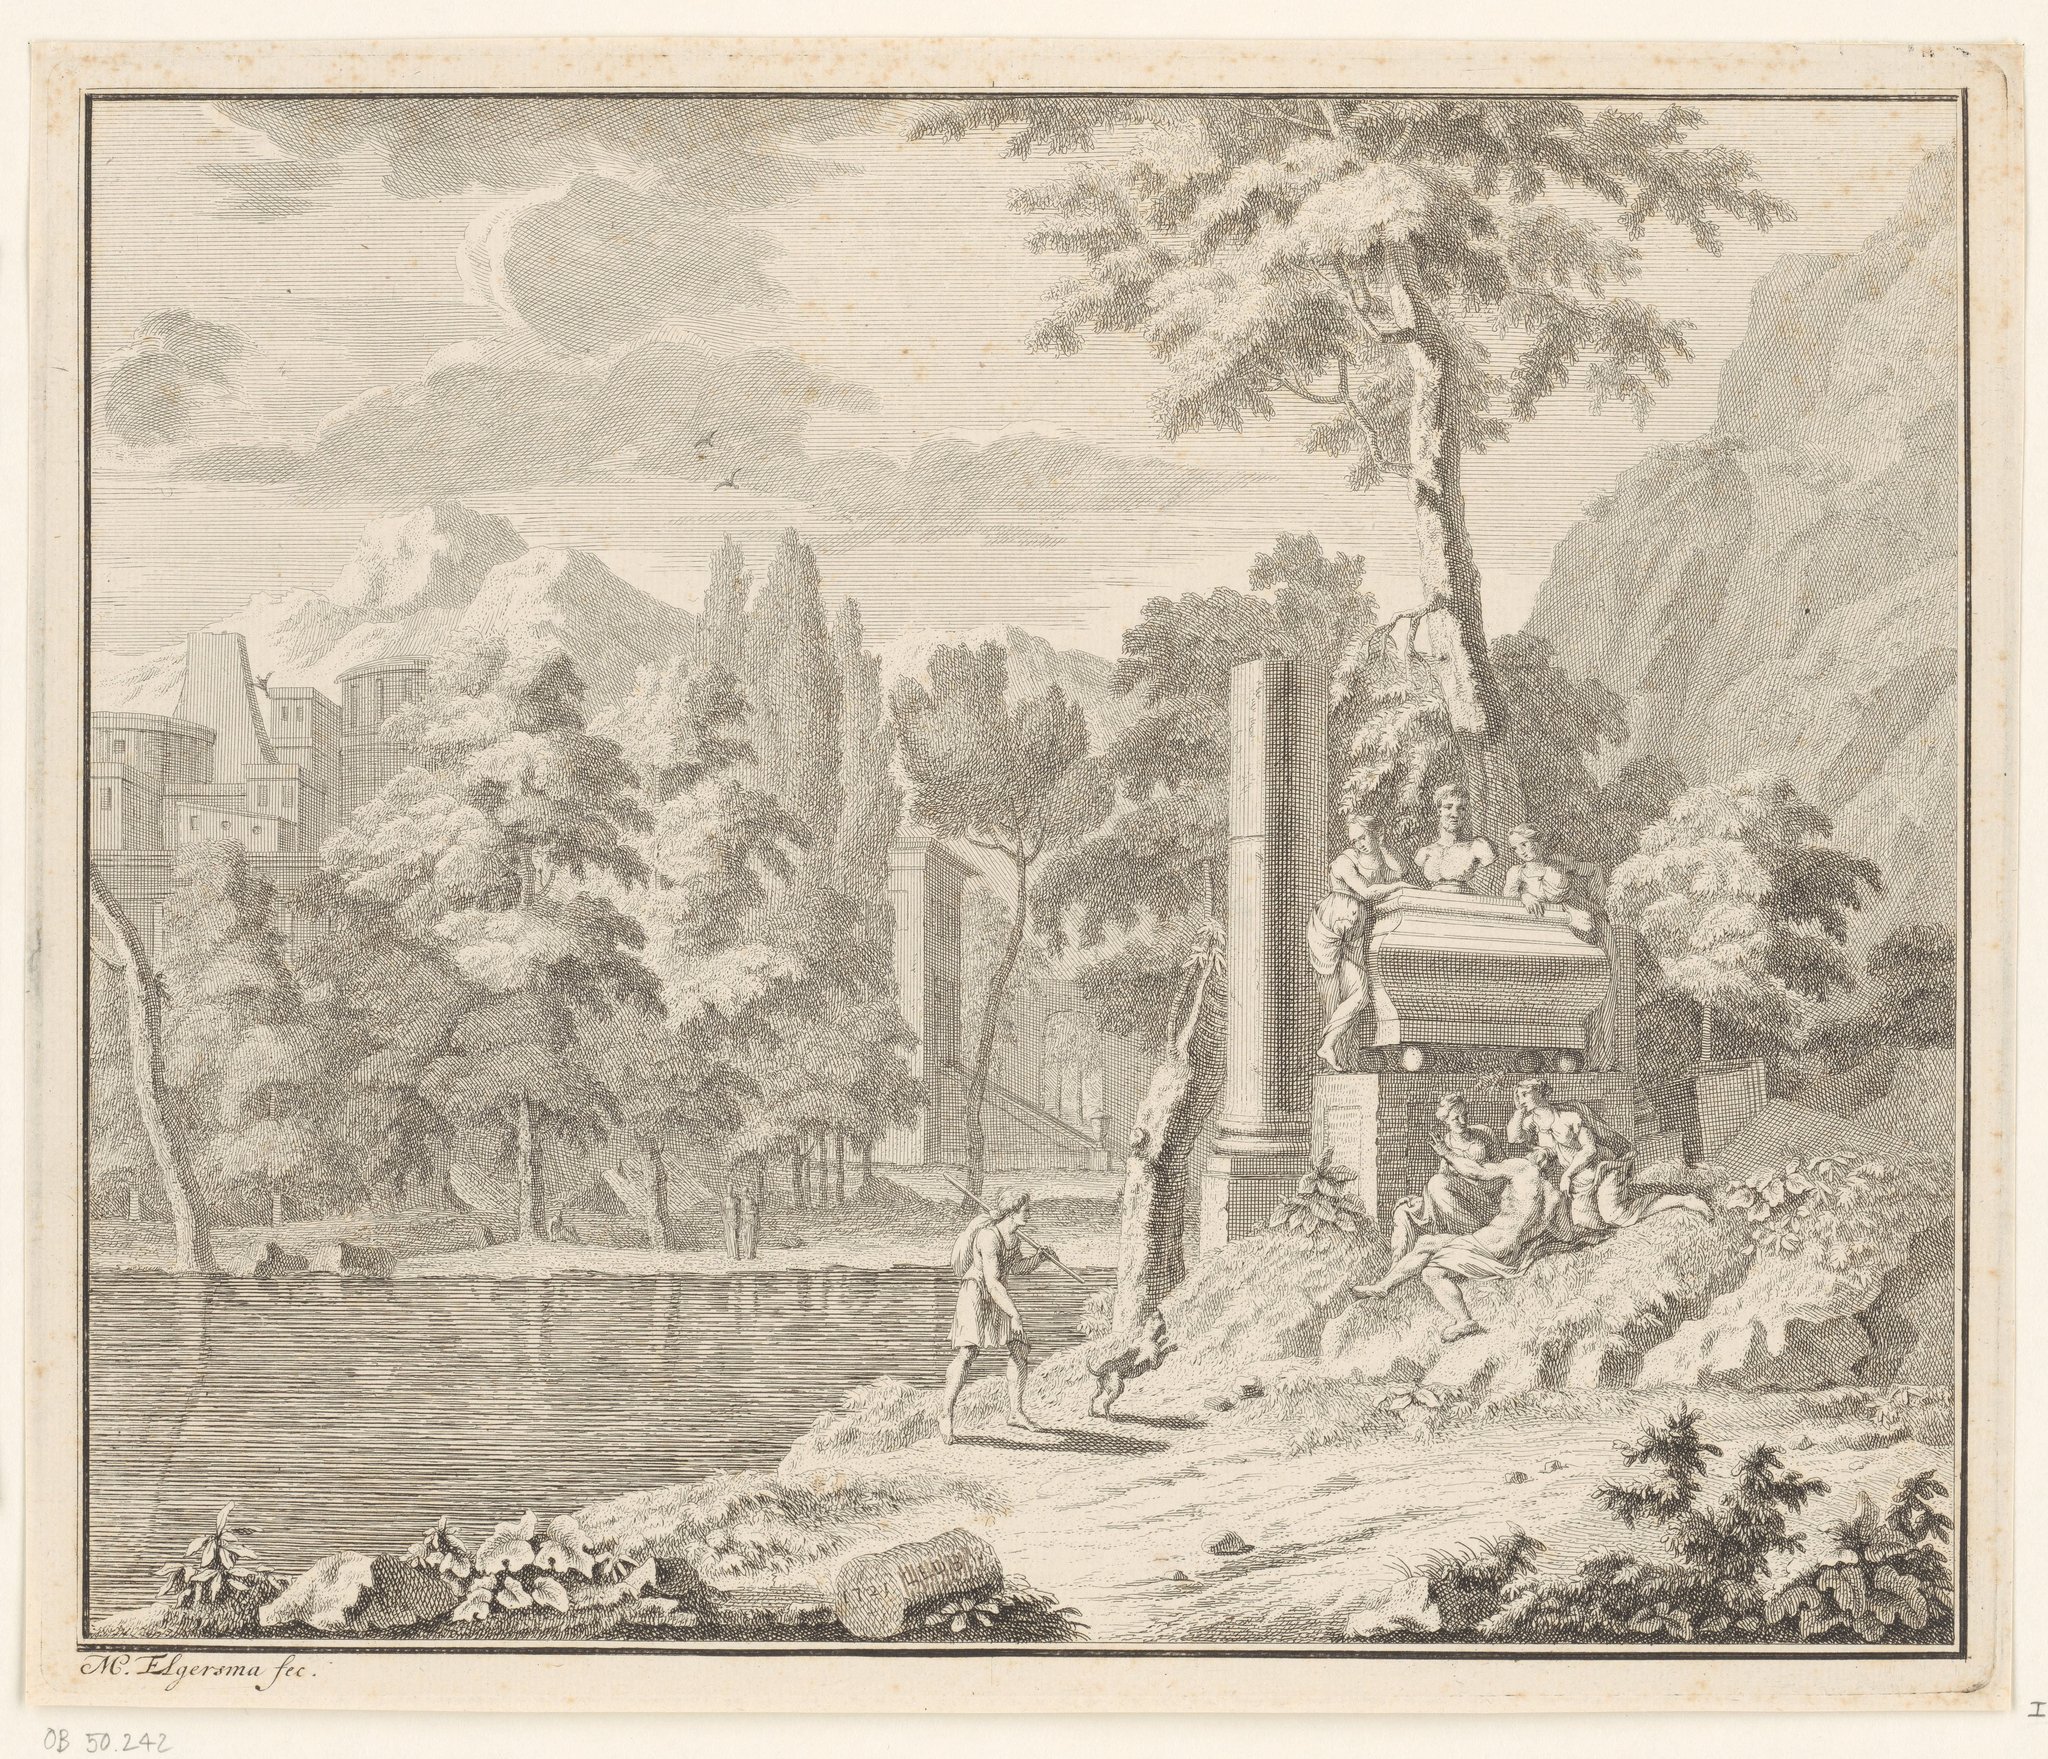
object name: print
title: Arcadisch landschap met graftombe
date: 1721-1759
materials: paper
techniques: etching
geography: netherlands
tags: pastorals, arcadian scenes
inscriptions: collector's mark: Lugt 240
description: Bergachtig landschap met een stad op de achtergrond. Langs een meer loopt een man met een hond in de richting van twee vrouwen en een rustende man. Op een verhoging staat een graftombe met een borstbeeld en aan weerszijden een vrouw.